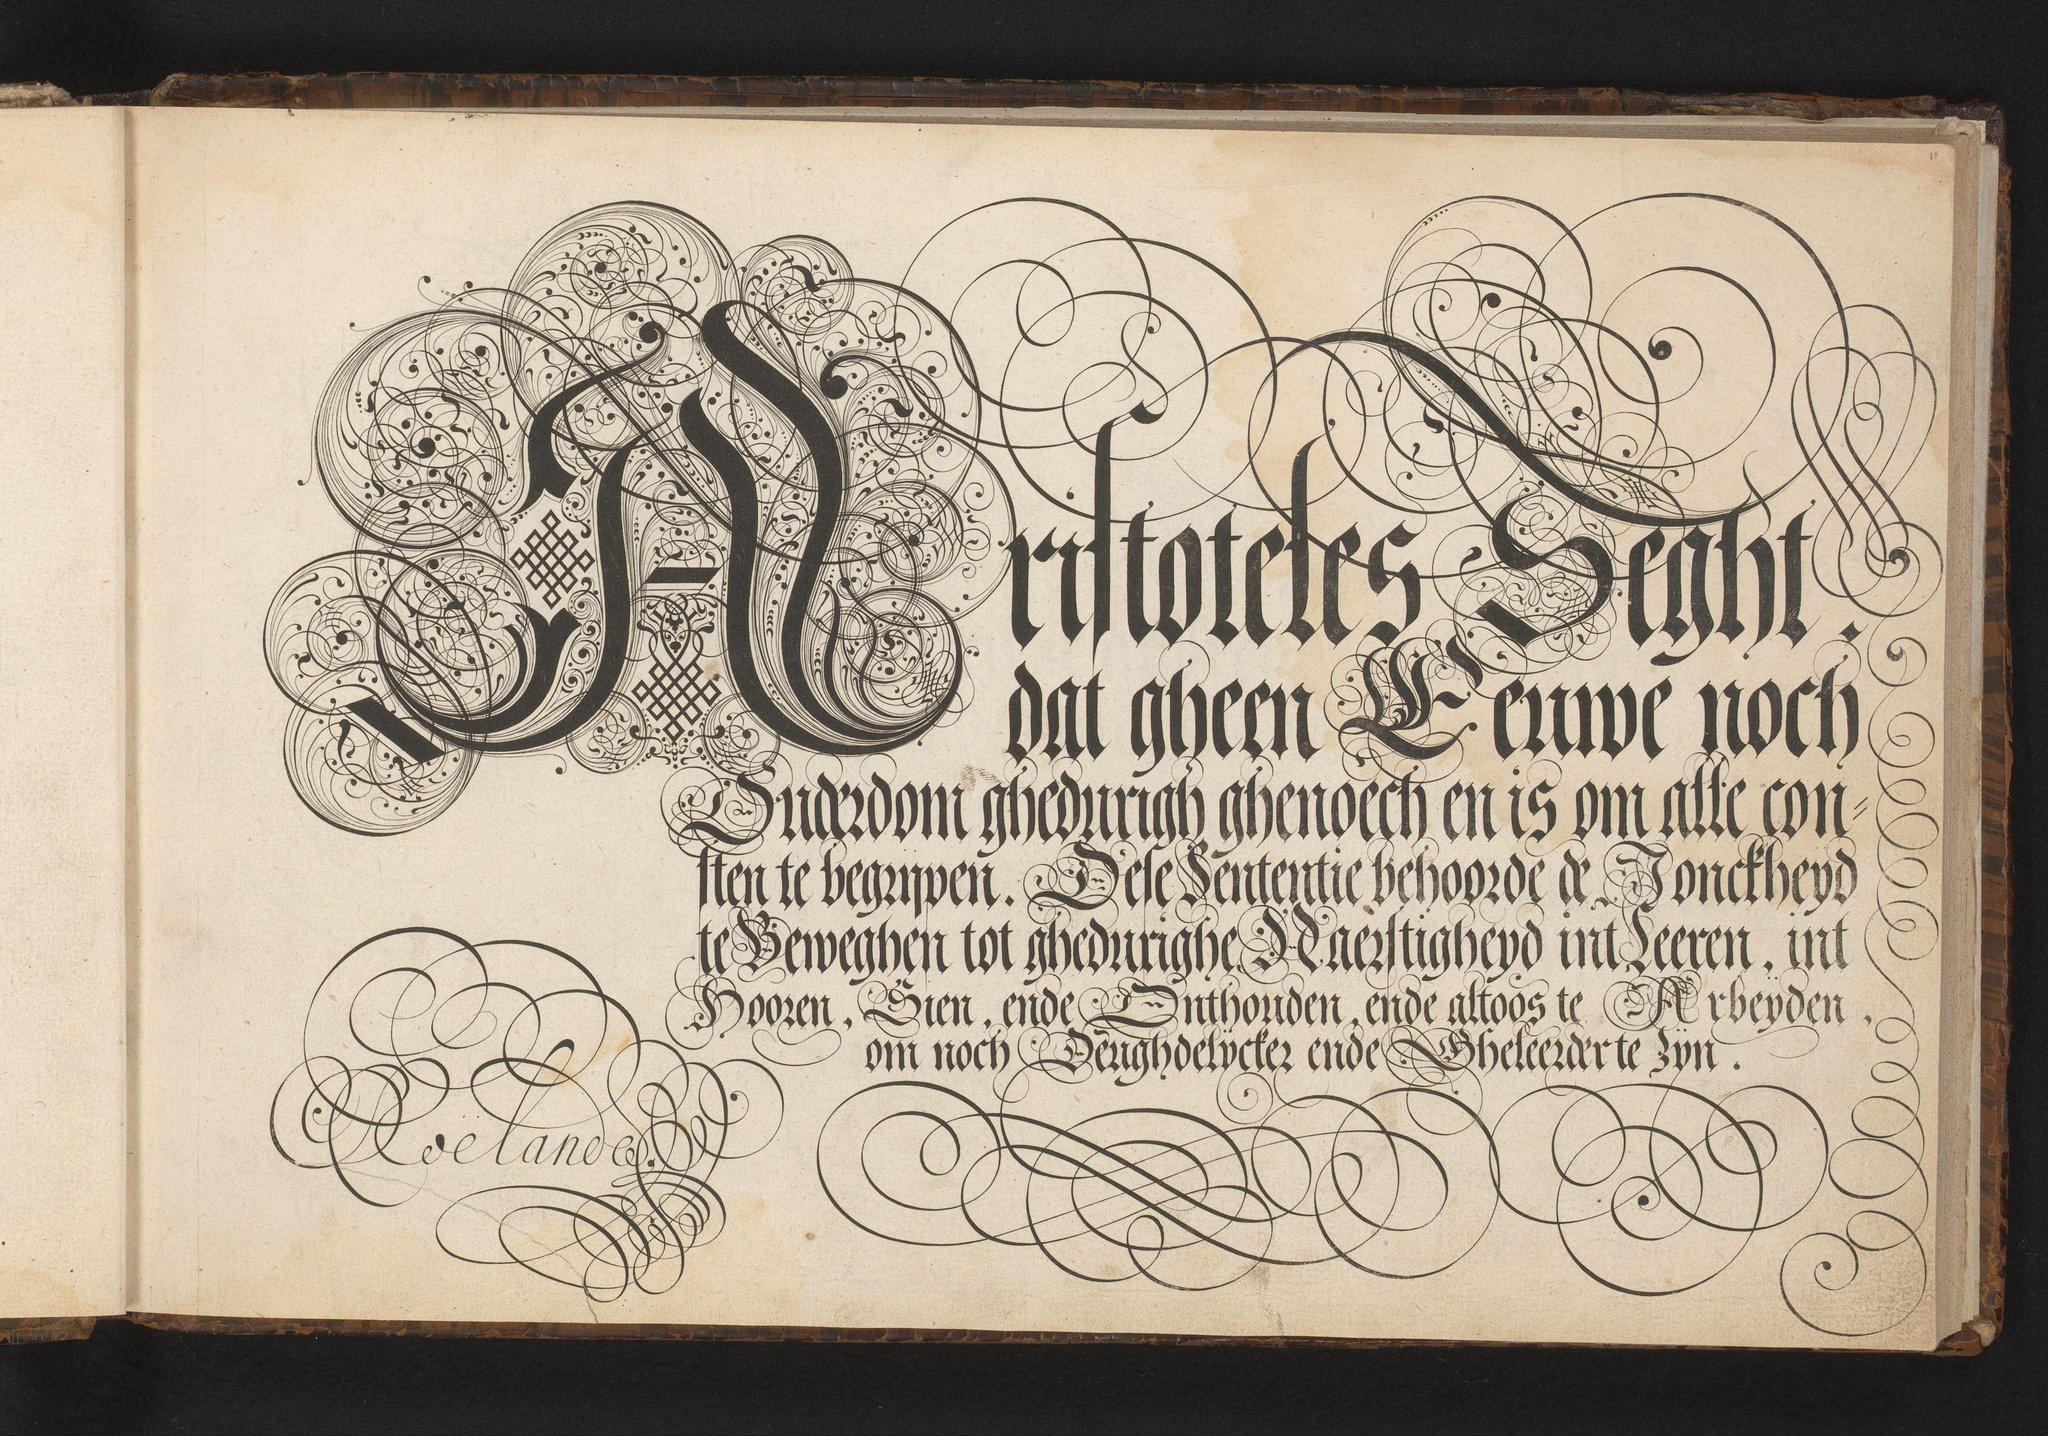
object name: print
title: Schrijfvoorbeeld: Aristoteles Seght (...)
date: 1616-1617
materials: paper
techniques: engraving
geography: flushing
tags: calligraphy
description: Schrijfvoorbeeld met geornamenteerde initiaal A en zeven regels tekst in het Nederlands: Aristoteles Seght ... De prent maakt deel uit van een album.